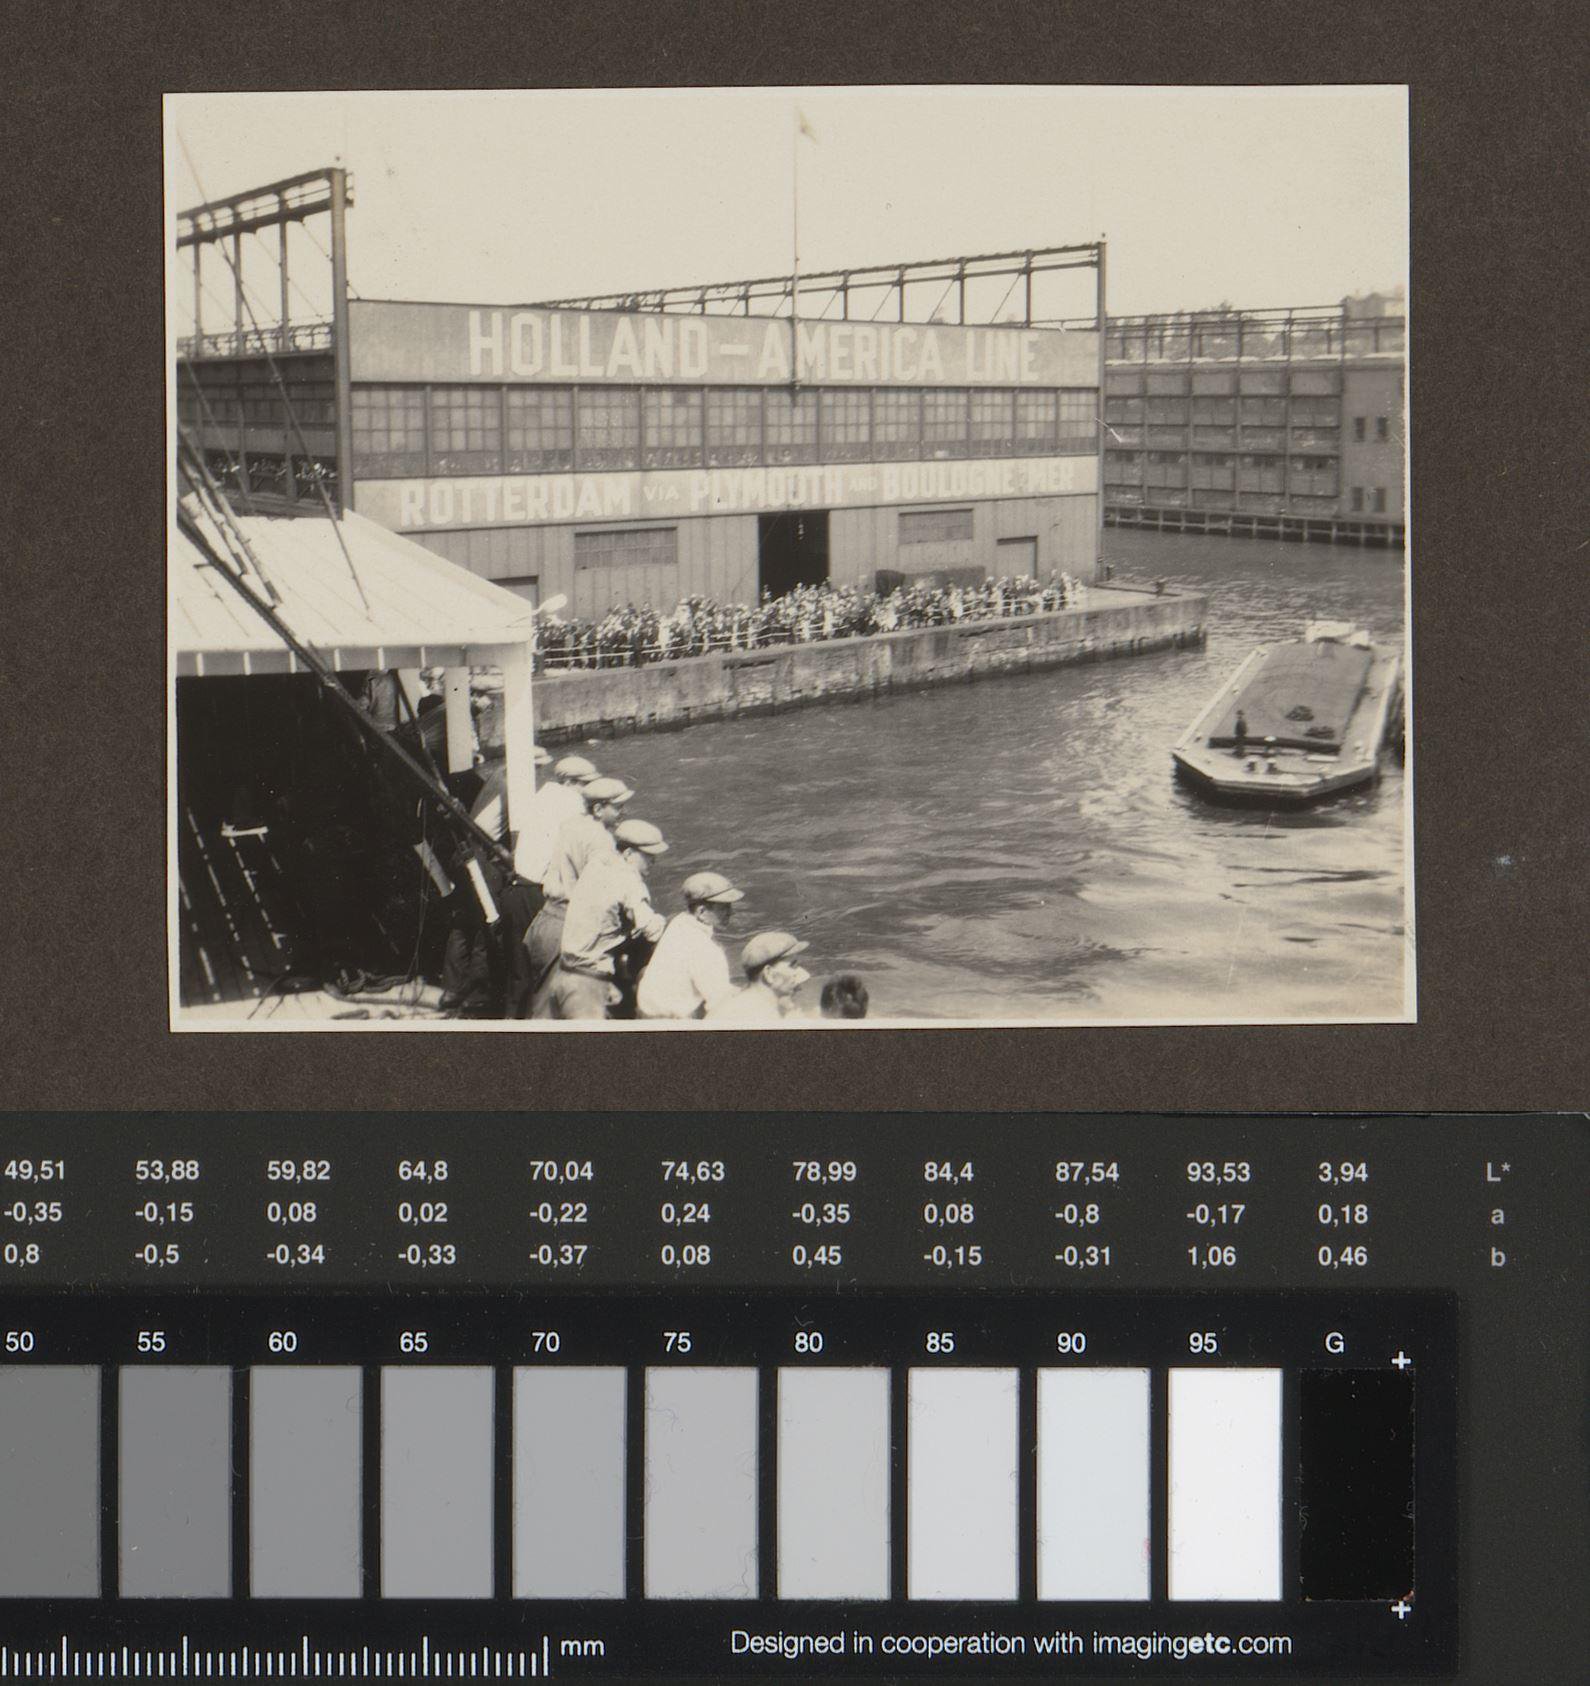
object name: album leaf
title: Aanlegplaats van de Holland-America Line in de haven van Hoboken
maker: Anonymous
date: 1928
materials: photographic support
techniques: gelatin silver print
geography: hoboken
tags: harbour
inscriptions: annotation: ‘Haven New York. Hoboken’